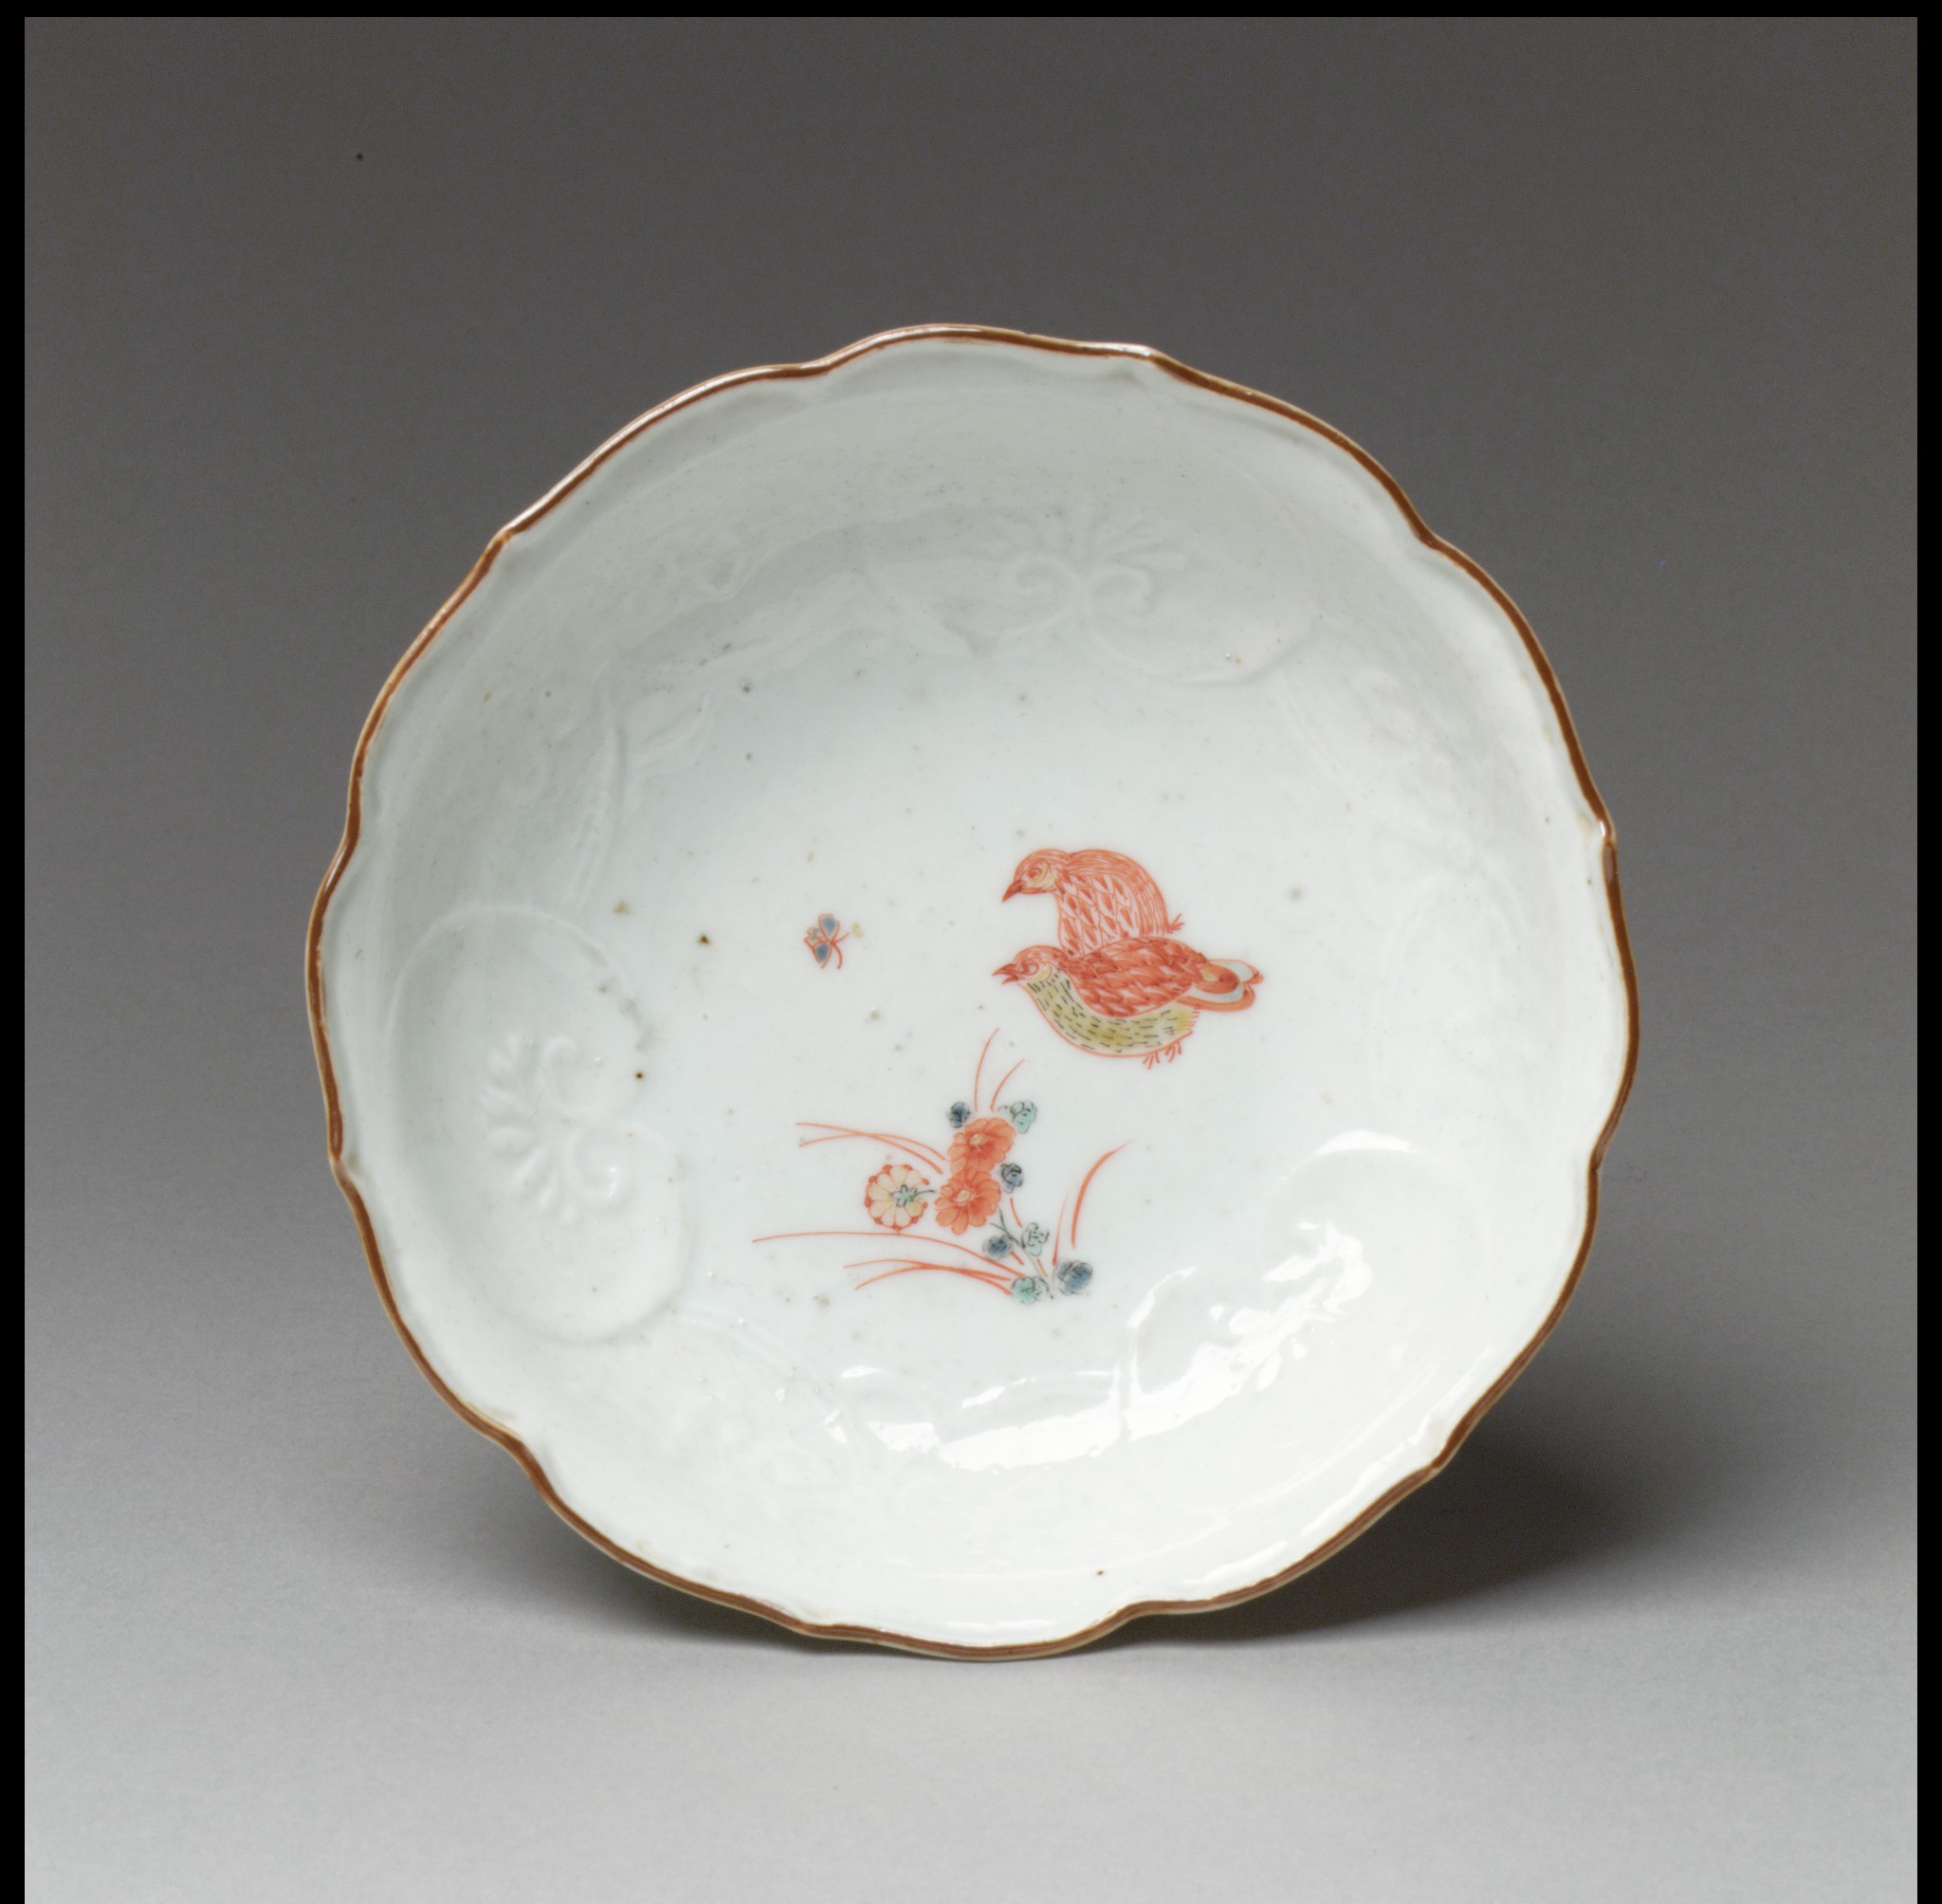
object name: bowl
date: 1710-1730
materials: hard paste porcelain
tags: birds,flowers